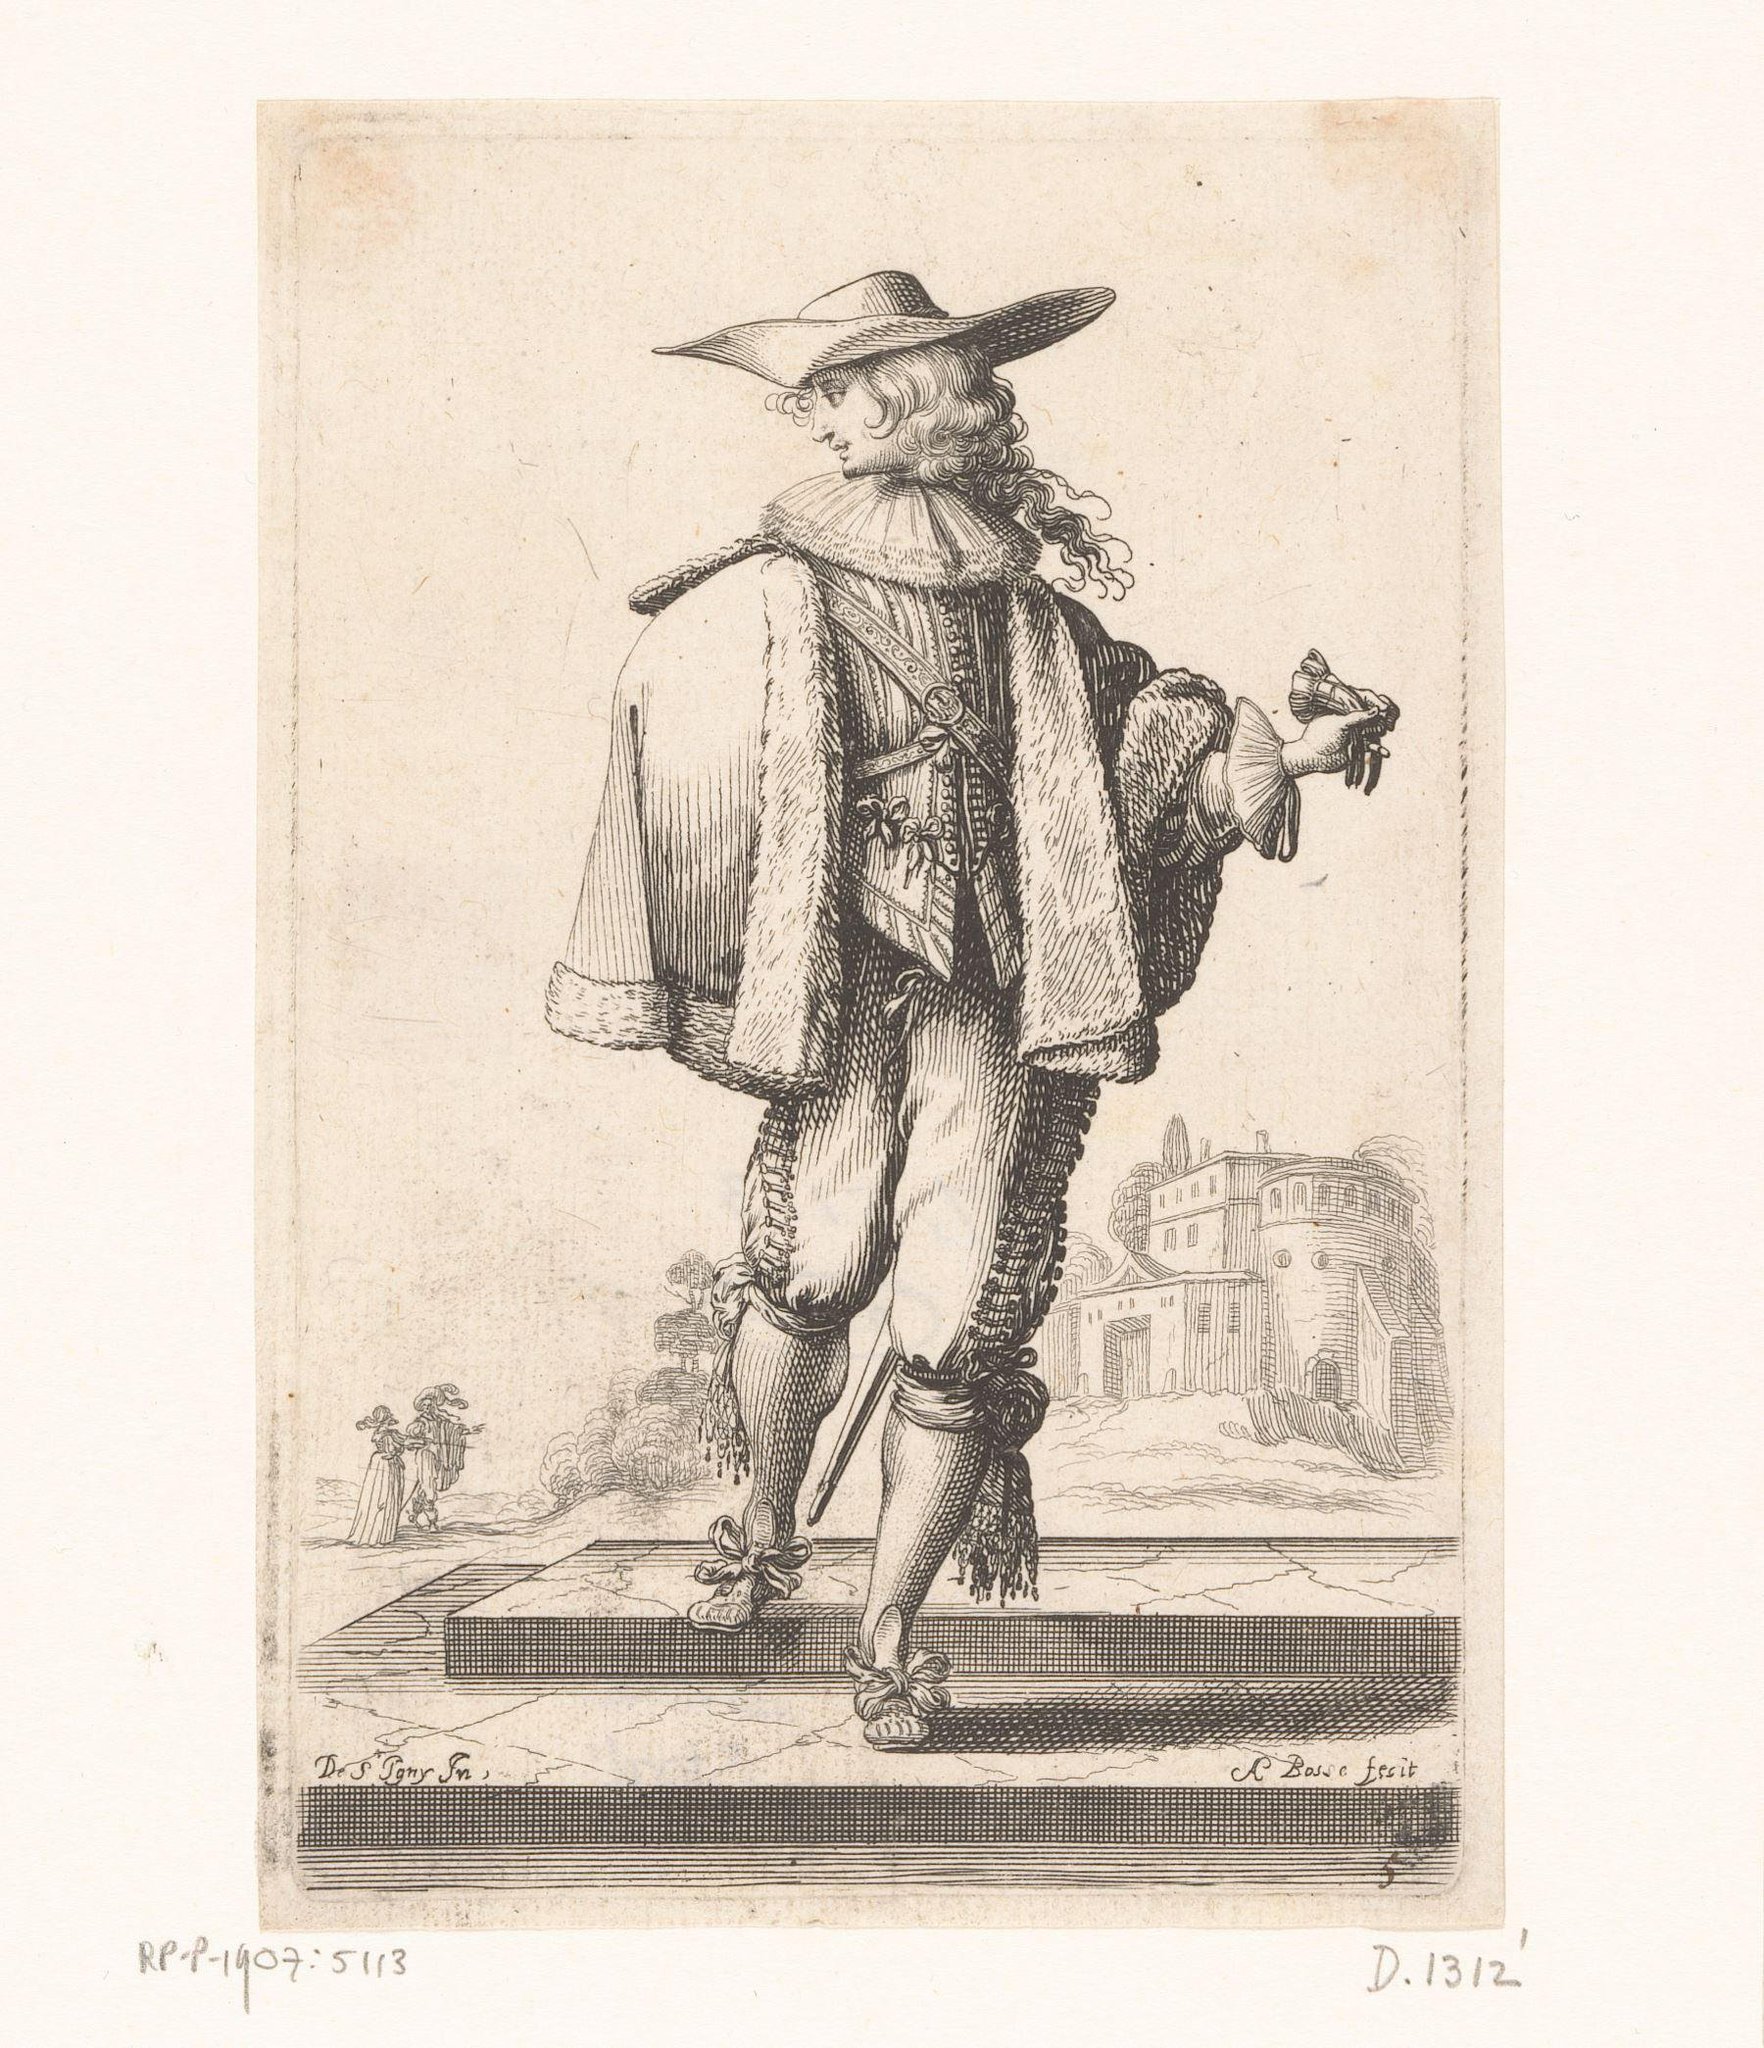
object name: costume print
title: Franse edelman, gekleed volgens de mode van ca. 1630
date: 1629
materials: paper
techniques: engraving, etching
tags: shoulder-belt, bandoleer (+ men's clothes), cape (+ men's clothes), head-gear: hat (+ men's clothes), styles of hairdress, handkerchief, europeans (with name), shoes, sandals (+ men's clothes), clothes, costume (+ men's clothes), neck-gear: collar (+ men's clothes), trousers, breeches, etc. (breeches) (+ men's clothes), clothing for the upper part of the body (doublet) (+ men's clothes), hacking and thrusting weapons (foil), gloves, mittens, etc. (+ men's clothes), stockings, socks (+ men's clothes)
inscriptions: number: ‘5’, collector's mark: Lugt 2228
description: Edelman, staand op een bordes, gekleed in een korte schoudermantel met bontrand over een wambuis en een kniebroek met strikken. Op het hoofd een platte hoed met brede rand, zonder pluimen, waaronder zijn lange haar tot op de schouders valt. Aan zijn voeten schoenen met strikken. In zijn linkerhand een handschoen. Degen aan de linkerzijde.